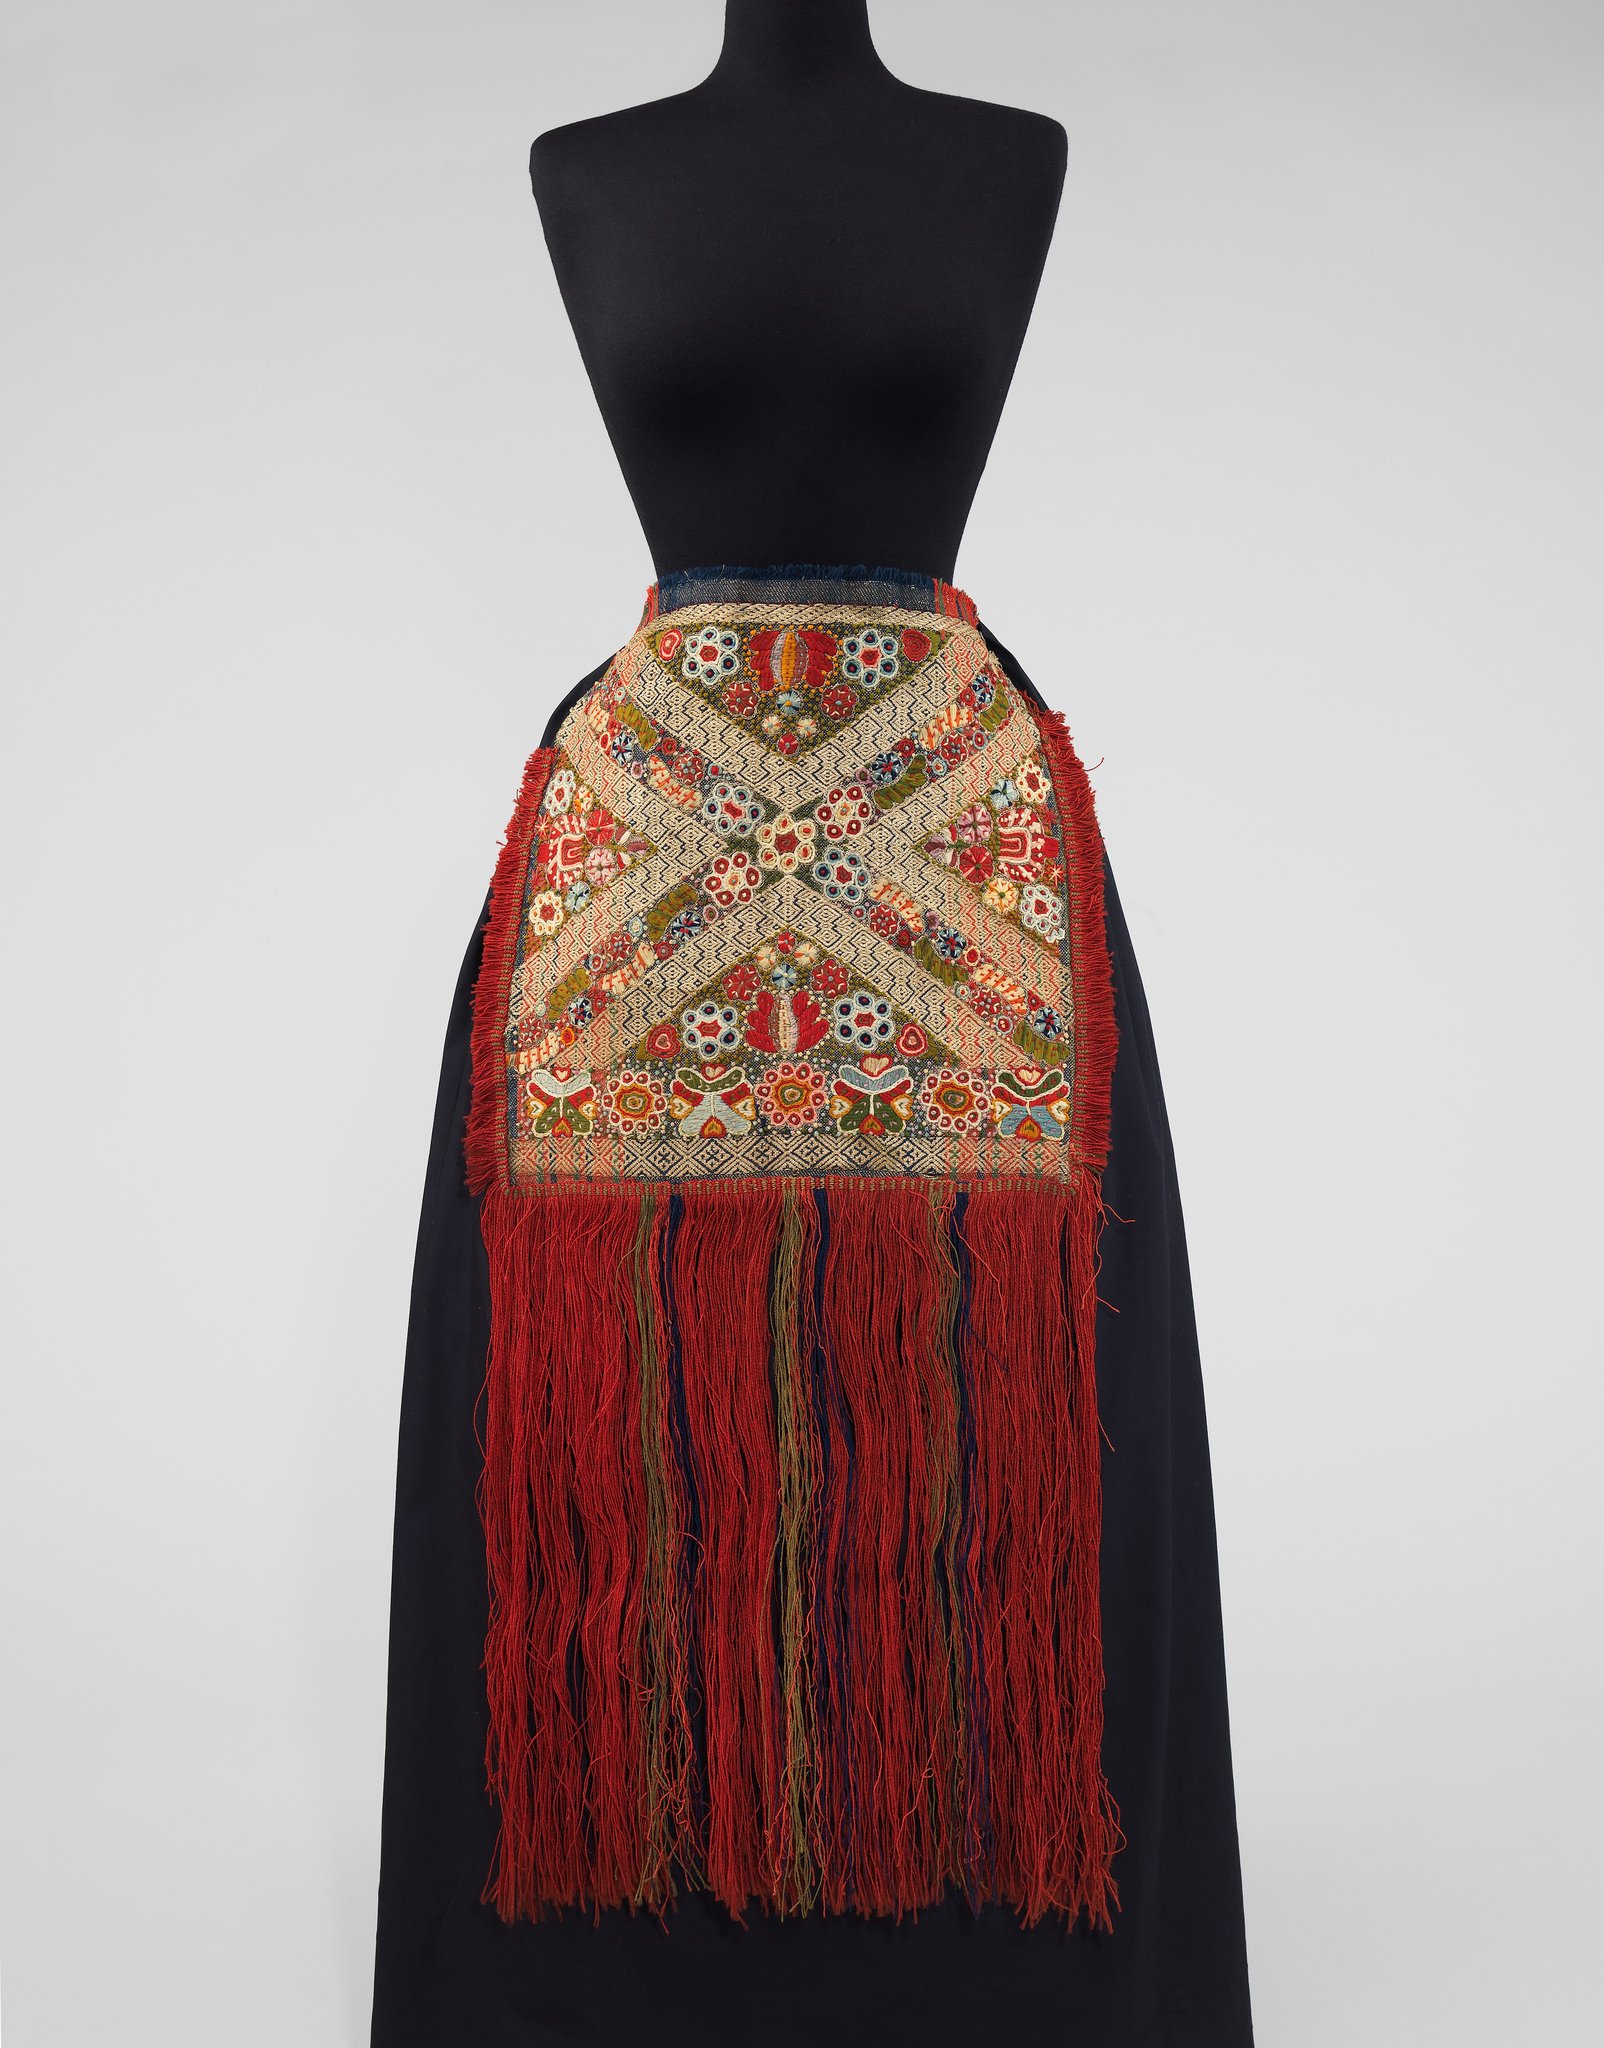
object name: apron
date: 1876-1900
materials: metal, wool